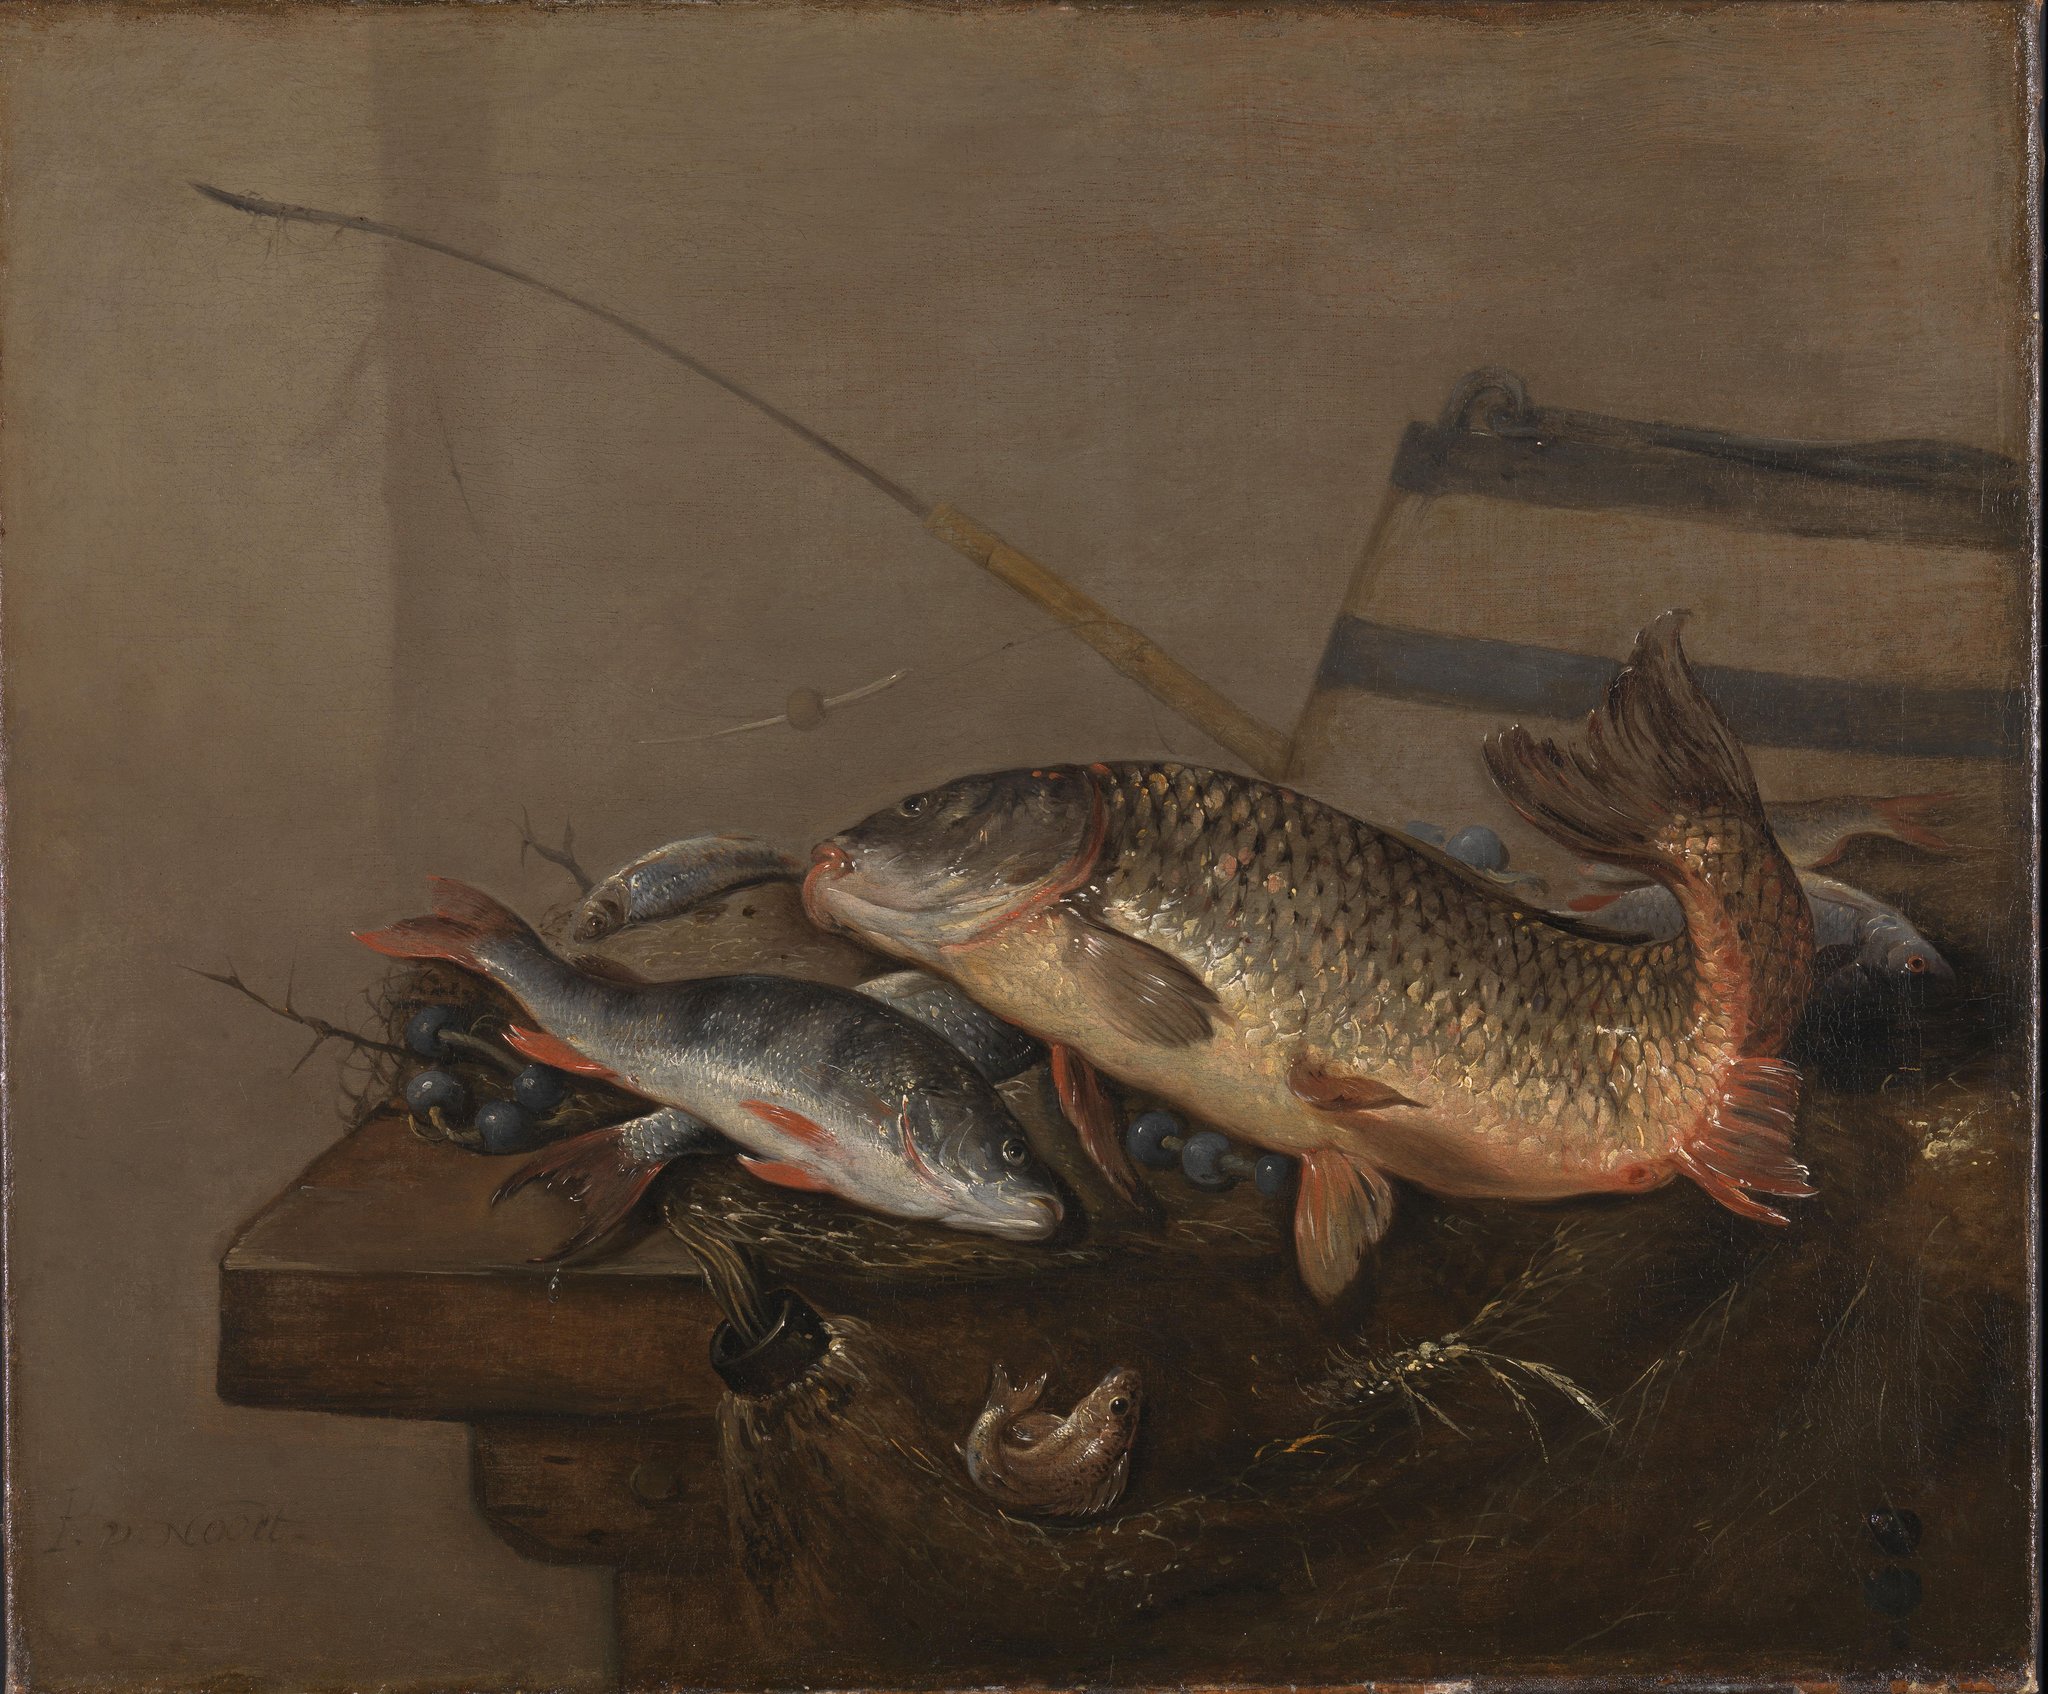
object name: painting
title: Still life with fish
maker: pieter van noort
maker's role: painter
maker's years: 1622-1672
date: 1648-1672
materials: canvas, oil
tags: fishes, fish; still life of fishes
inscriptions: signature: ‘P. v. Noort’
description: Visstilleven. Stilleven met verschillende soorten vis (karper, baars) uitgestald op een visnet op de hoek van een tafel. Op de achtergrond een hengel met lijn en dobber en een emmer.